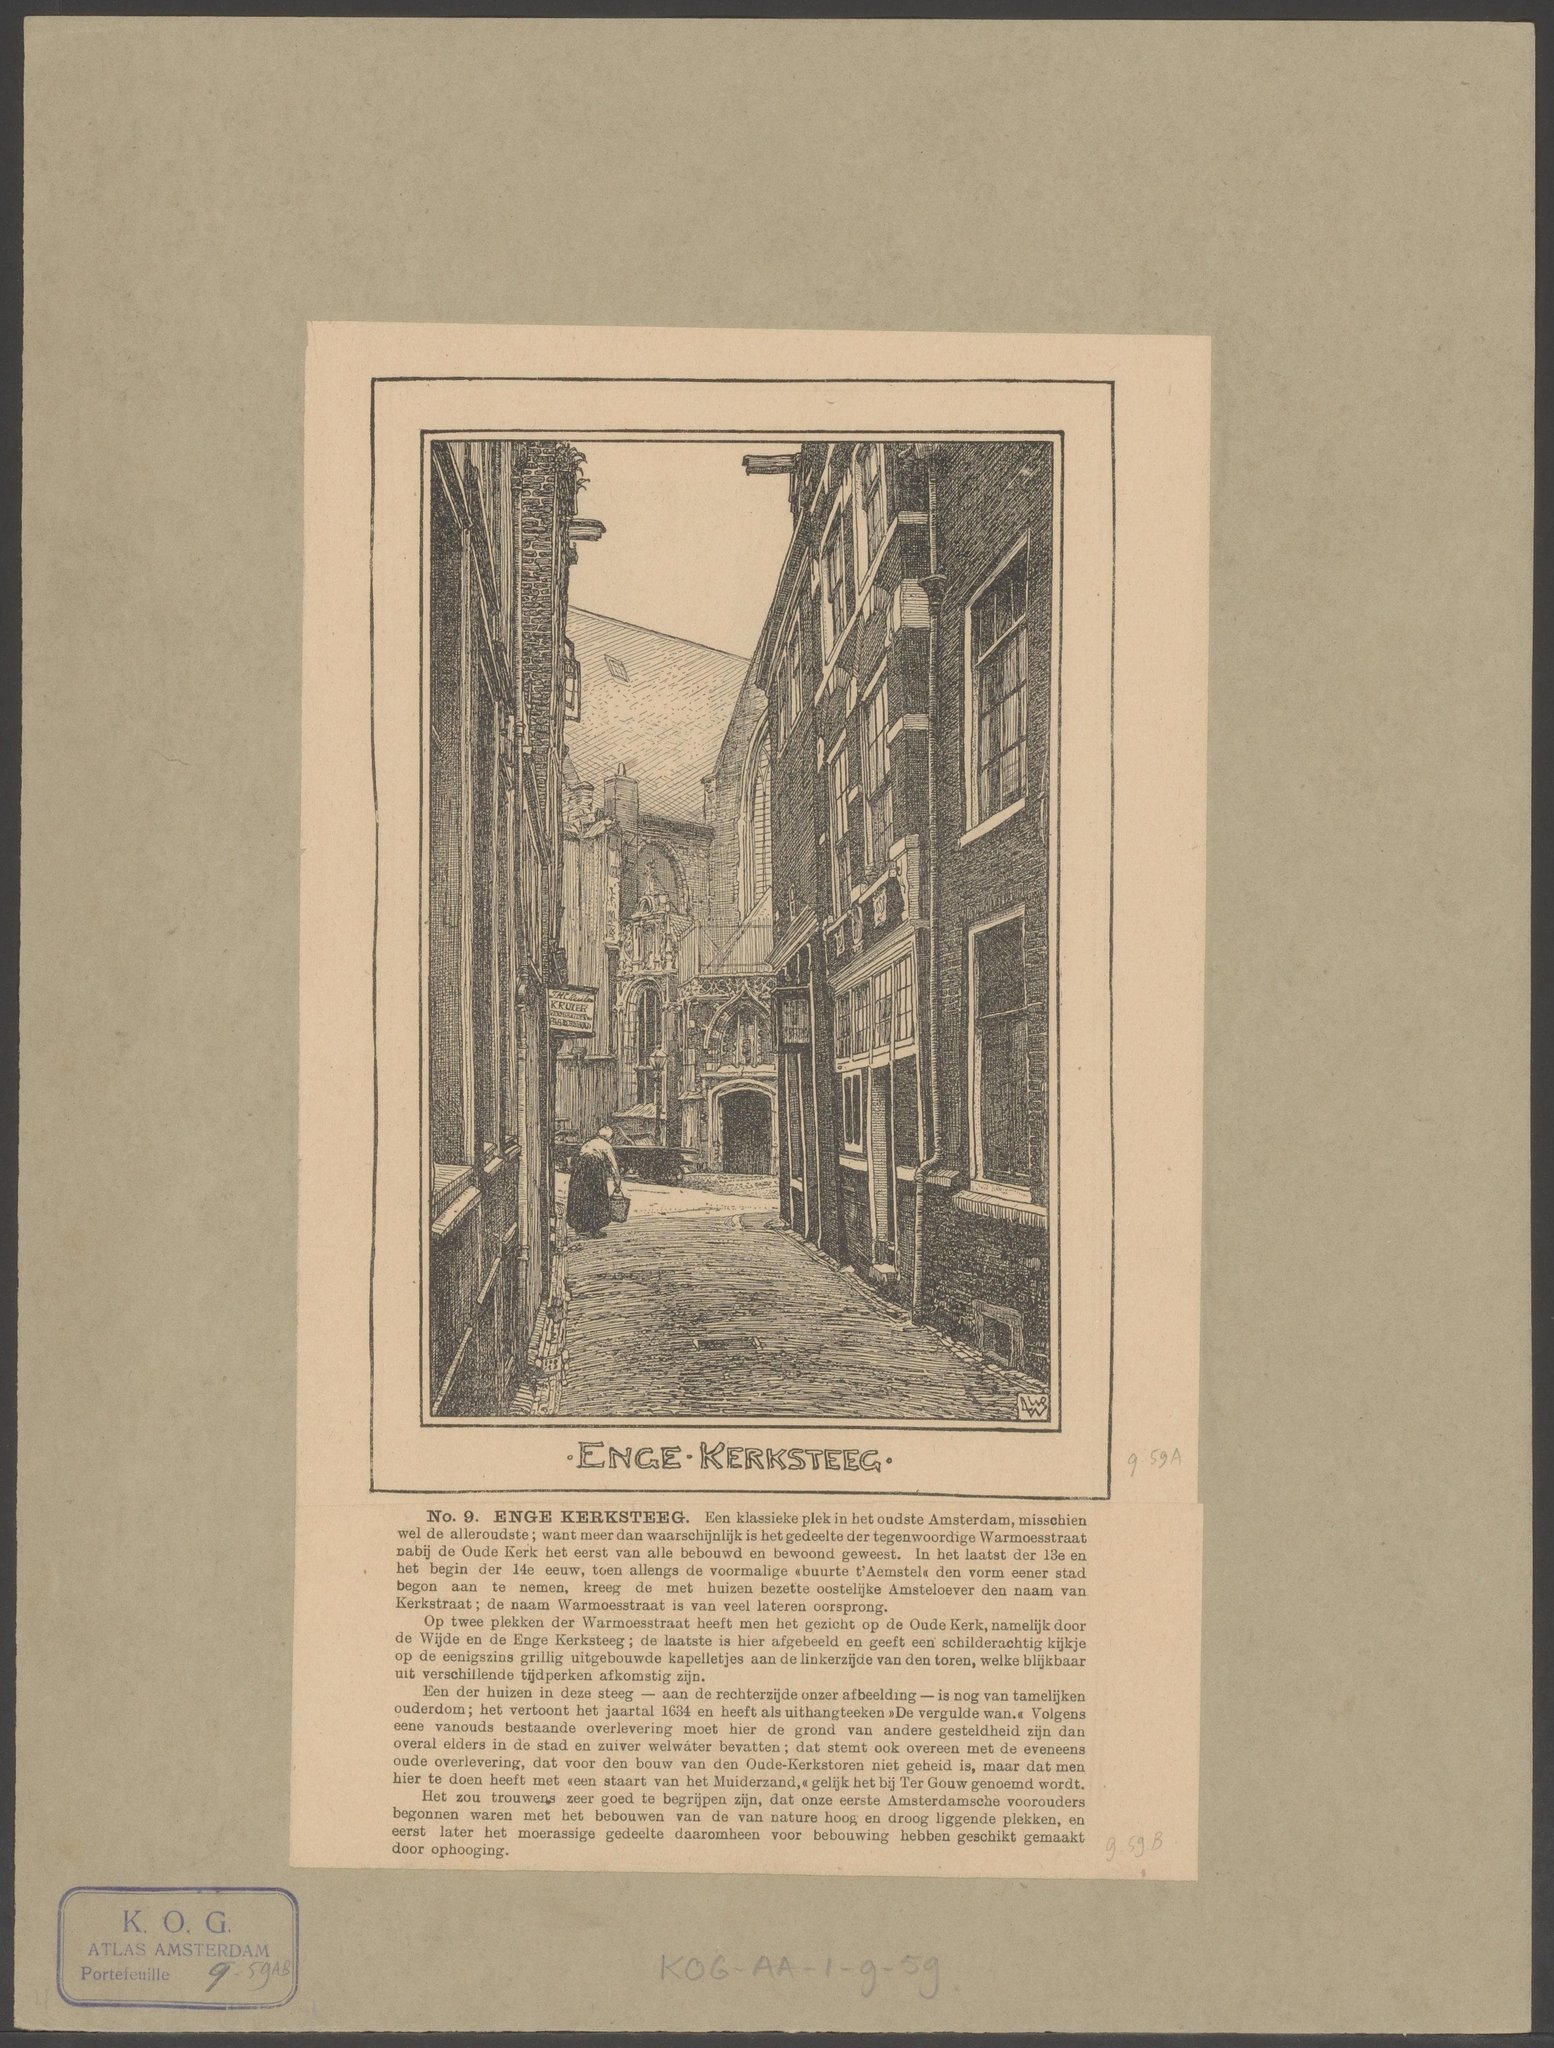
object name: photomechanical print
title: Oud-Amsterdam 100 Stadsgezichten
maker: willem wenckebach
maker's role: designer, draughtsman, painter, print maker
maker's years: 1860-1937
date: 1870-1923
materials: paper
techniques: letterpress printing, line block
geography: amsterdam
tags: city-view in general; 'veduta', the usual house or row of houses, lane, alley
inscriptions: collector's mark: ‘9,59AB’ Lugt 1641b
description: Onderwerpsrubriek binnen de Atlas Amsterdam: Kadijksplein, Karthuizerkerkhof, Kattegat, Kattenburg, Kapelsteeg O.Z., Enge Kerksteeg, Kerkstraat, Kinkerstraat, Kolk O.Z., Koningsplein, Kromboomsloot [Krom Boomssloot], Kostverlorenkade, Kwakersdwarspad, Kalverstraat, Keizersgracht (v.d. Brouwersgracht – Amstel), Klerensloot (Gedempte), Klimopstraat, Kloveniersburgwal, Kraansluis.